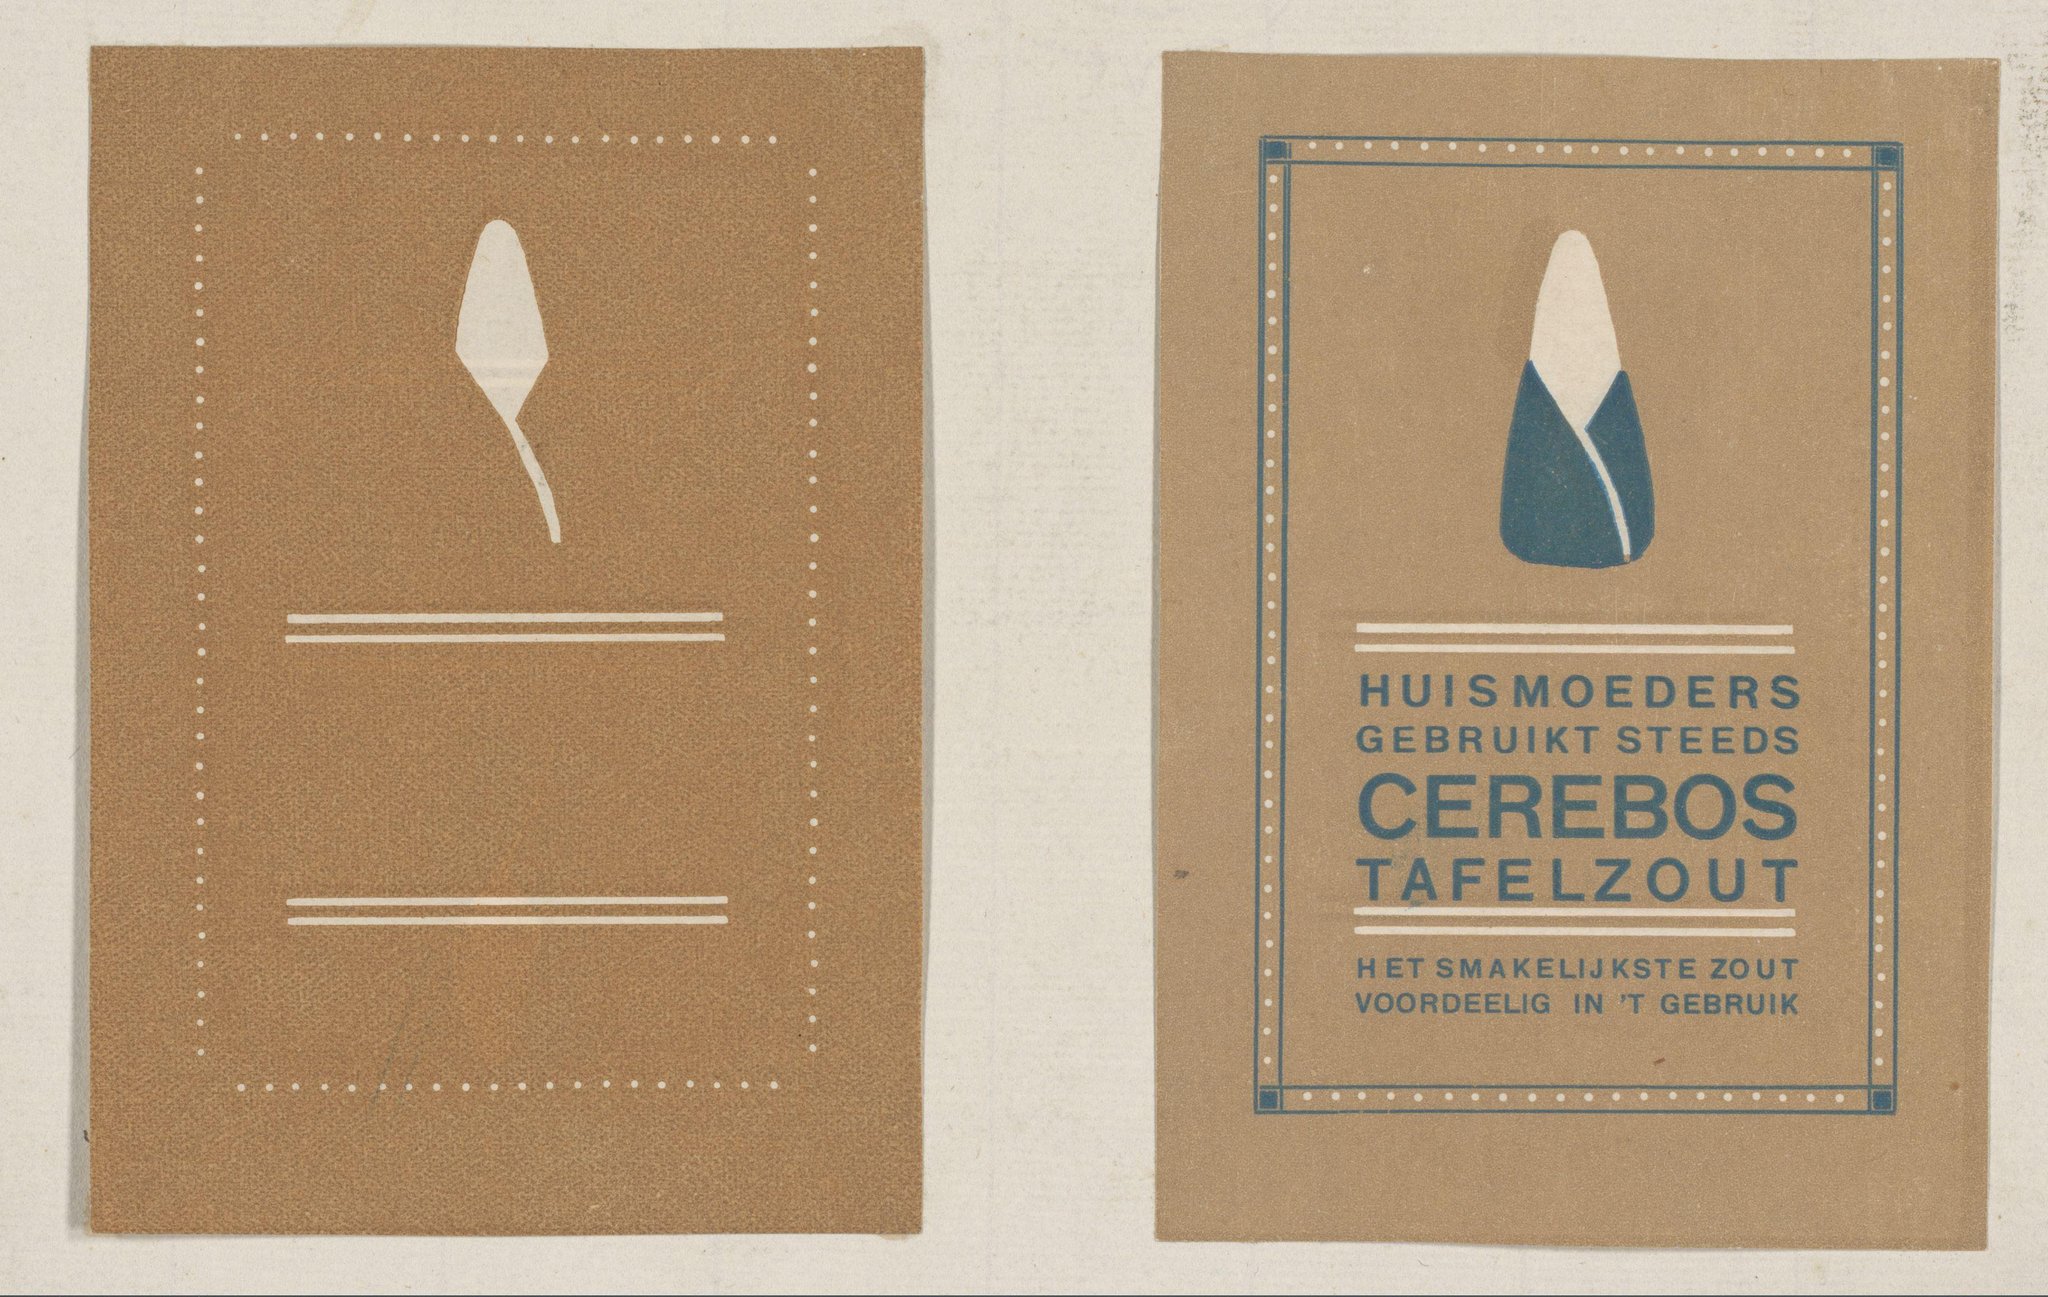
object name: photomechanical print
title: Advertentie voor Cerebos tafelzout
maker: reinier willem petrus de vries (1874-1953)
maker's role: draughtsman, print maker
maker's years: 1874-1953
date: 1884-1952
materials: paper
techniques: printing block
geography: hilversum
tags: salt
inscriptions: annotation: ‘R.W.P. de Vries Jr Hilversum’, number: ‘12.’